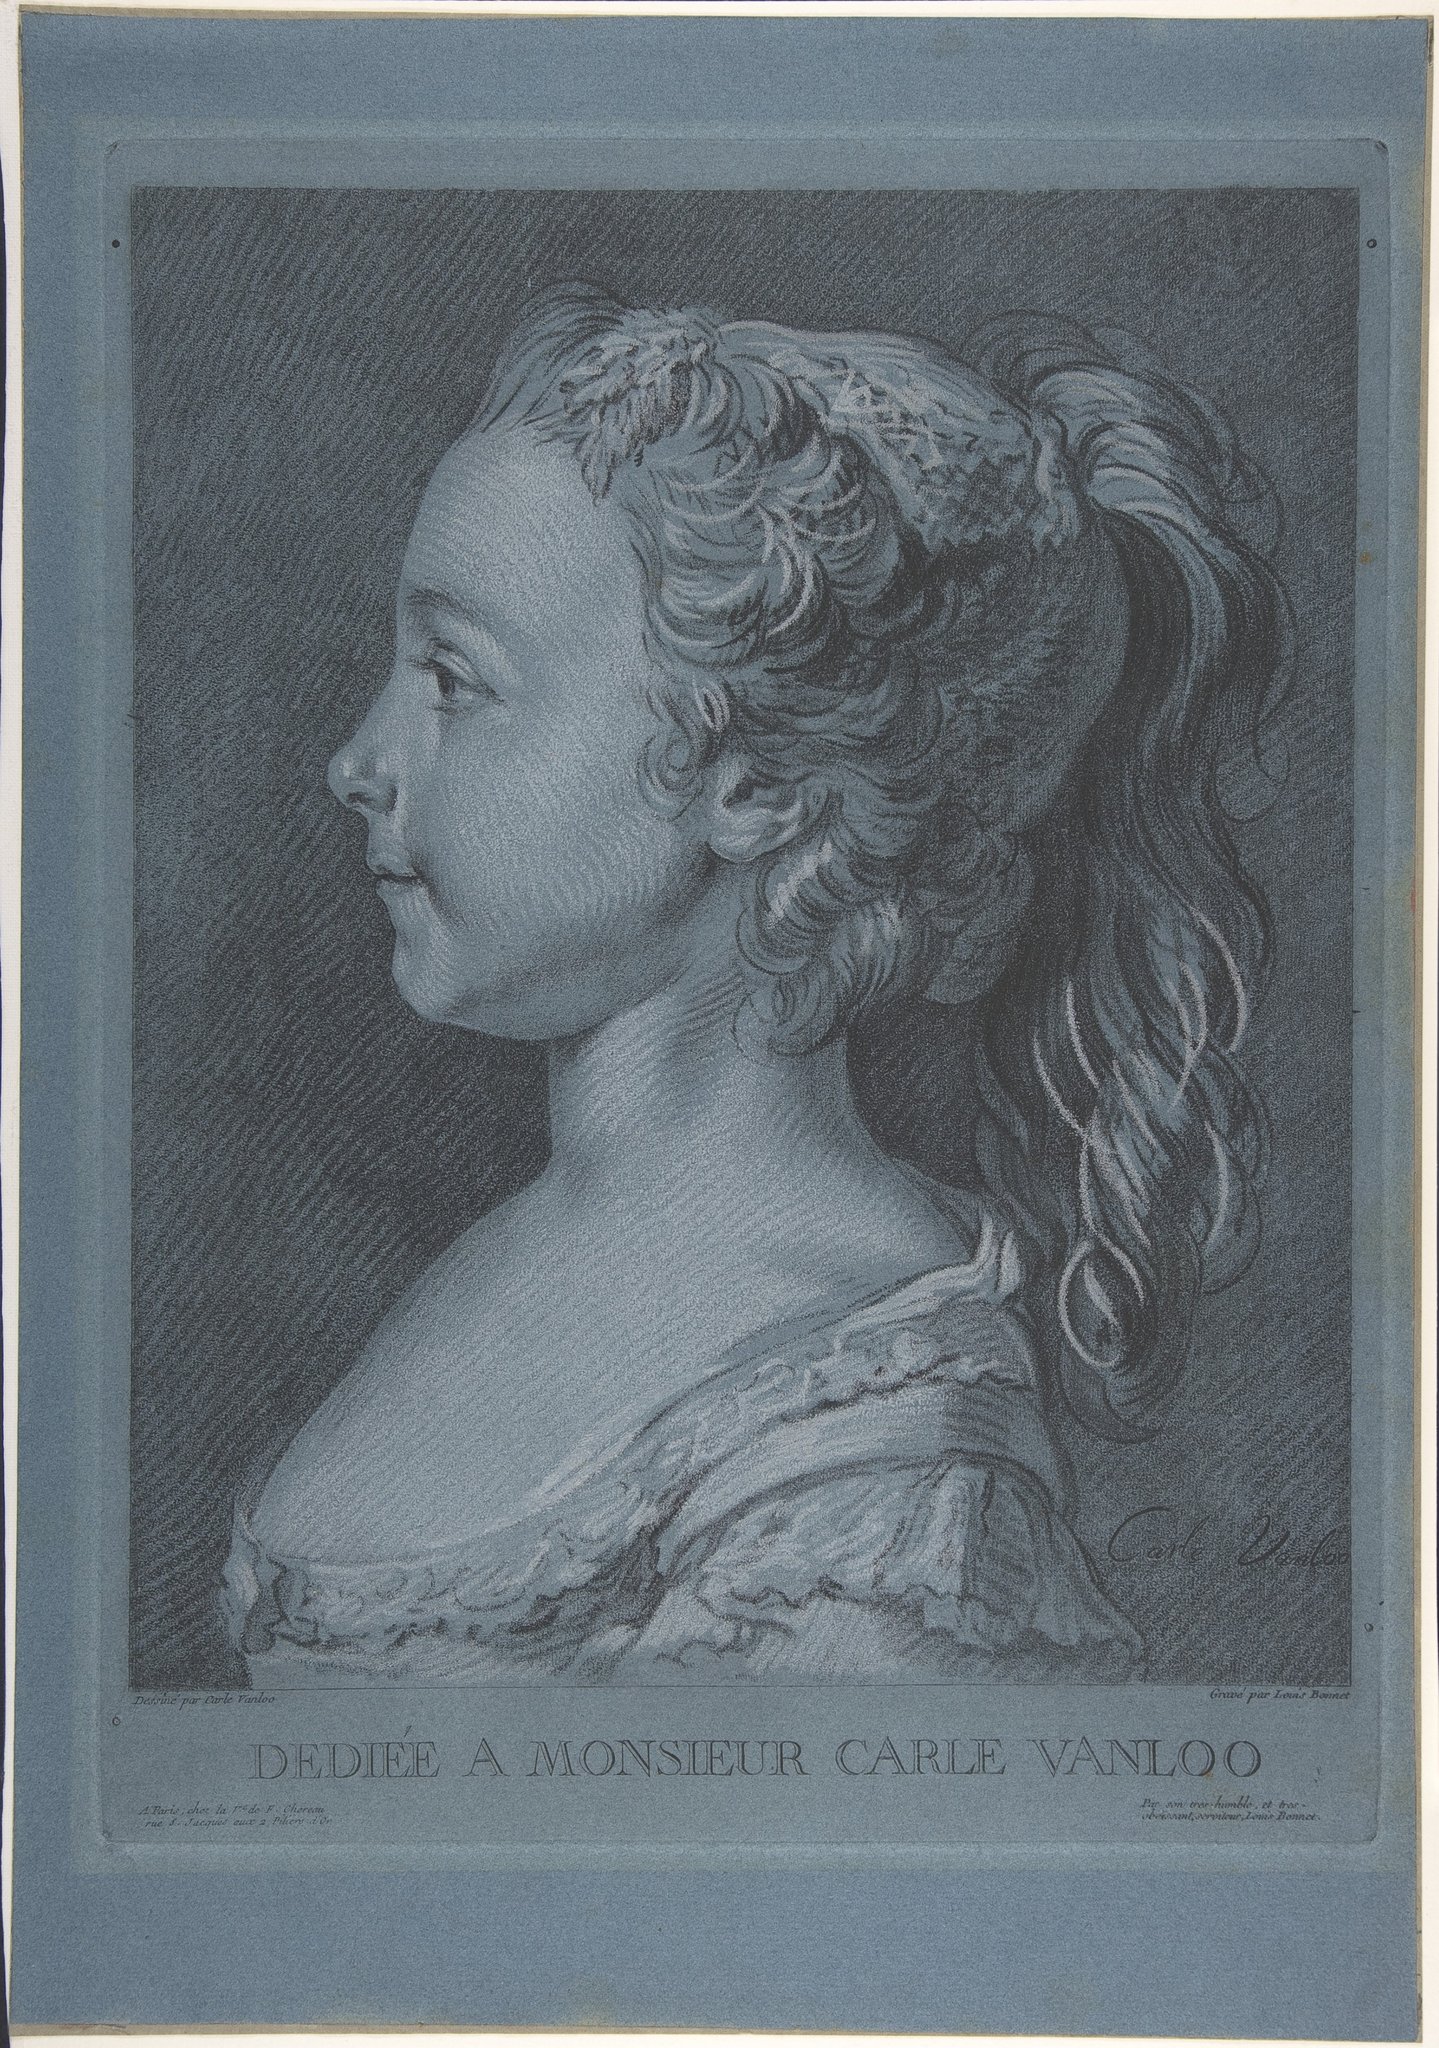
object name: print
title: Head of a Young Girl in Profile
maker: louis marin bonnet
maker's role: artist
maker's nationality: french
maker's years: 1736-1793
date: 1701-1800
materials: paper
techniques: printmaking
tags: girls